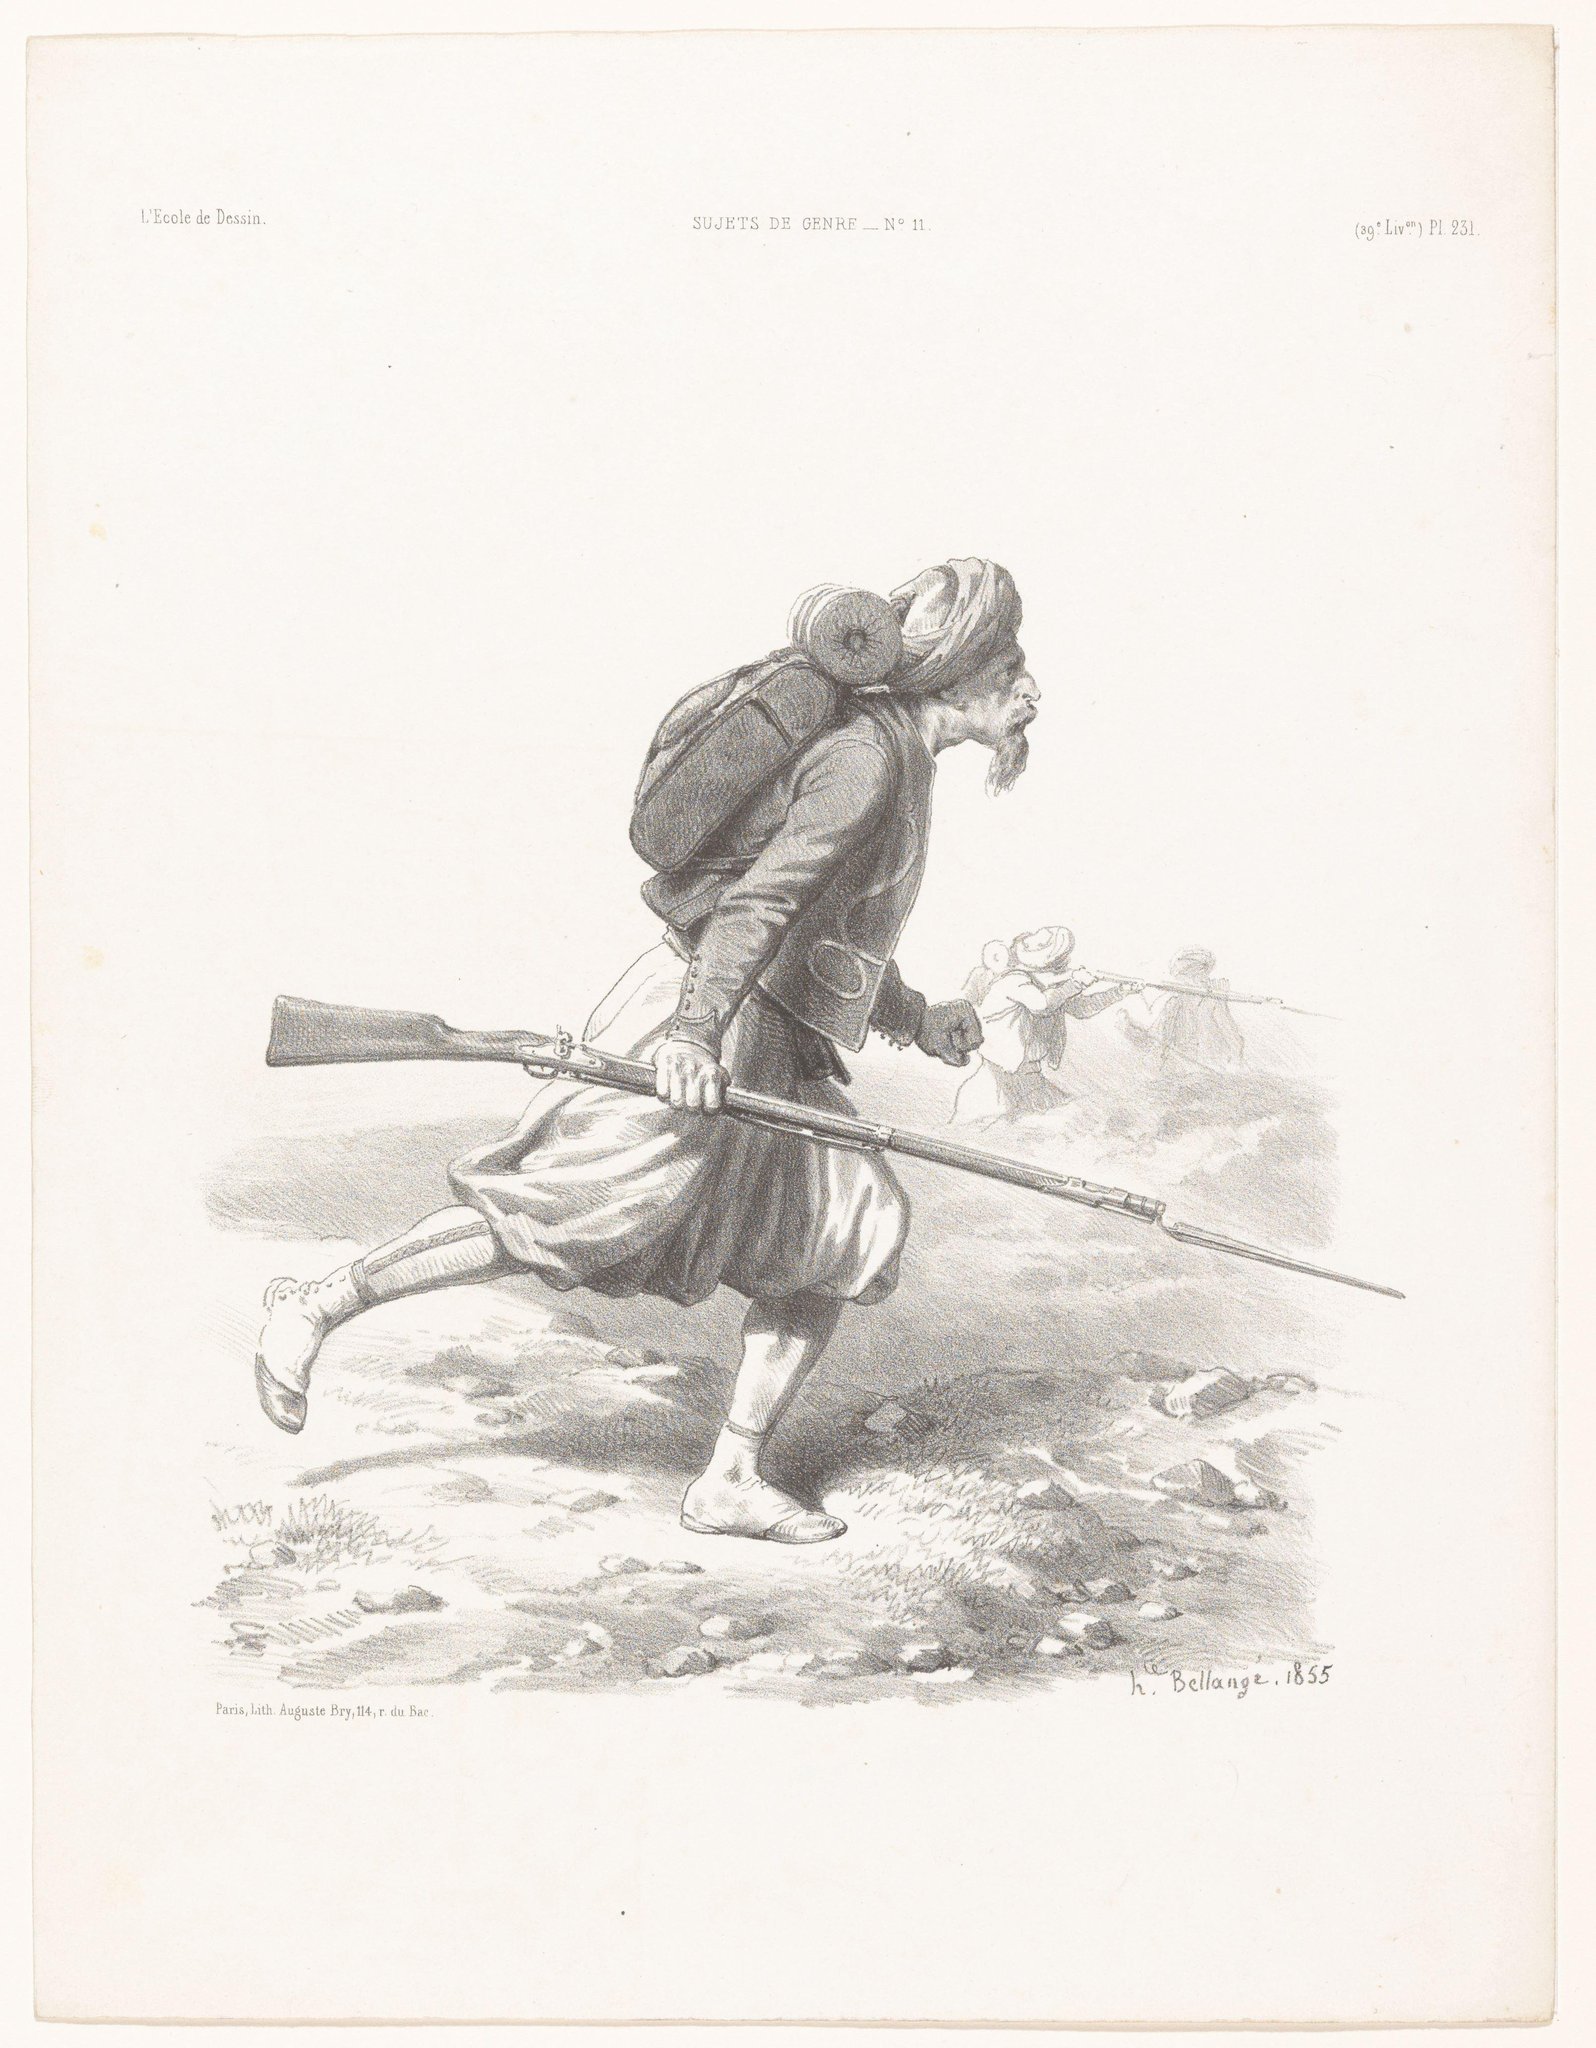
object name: print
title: L'école de dessin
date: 1855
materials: paper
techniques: lithograph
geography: paris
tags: colonial system, private soldier (+ infantry), private soldier (+ weapons)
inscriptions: collector's mark: Lugt 2228a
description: Gepubliceerd in: L'École de dessin. Livraison 39. Zoeaven, soldaten die werden geworven in Algerije, vormden vanaf 1831 een Frans legeronderdeel.